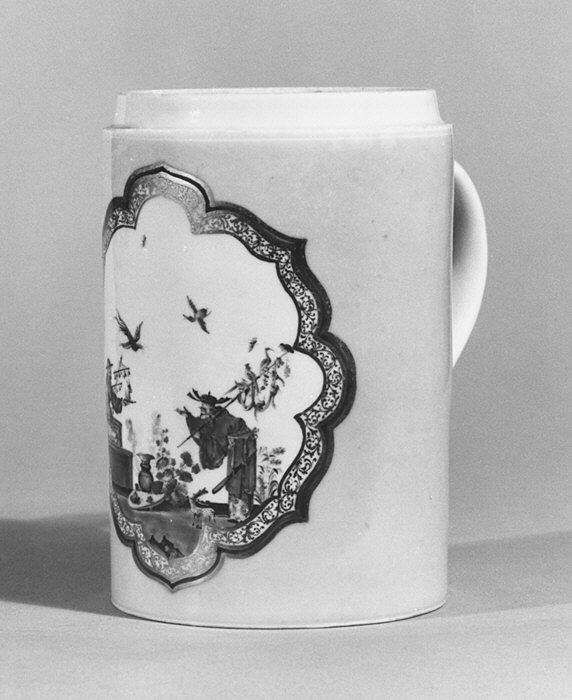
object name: tankard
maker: meissen manufactory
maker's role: manufactory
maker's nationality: german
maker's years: 1710-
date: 1740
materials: hard paste porcelain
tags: human figures,birds